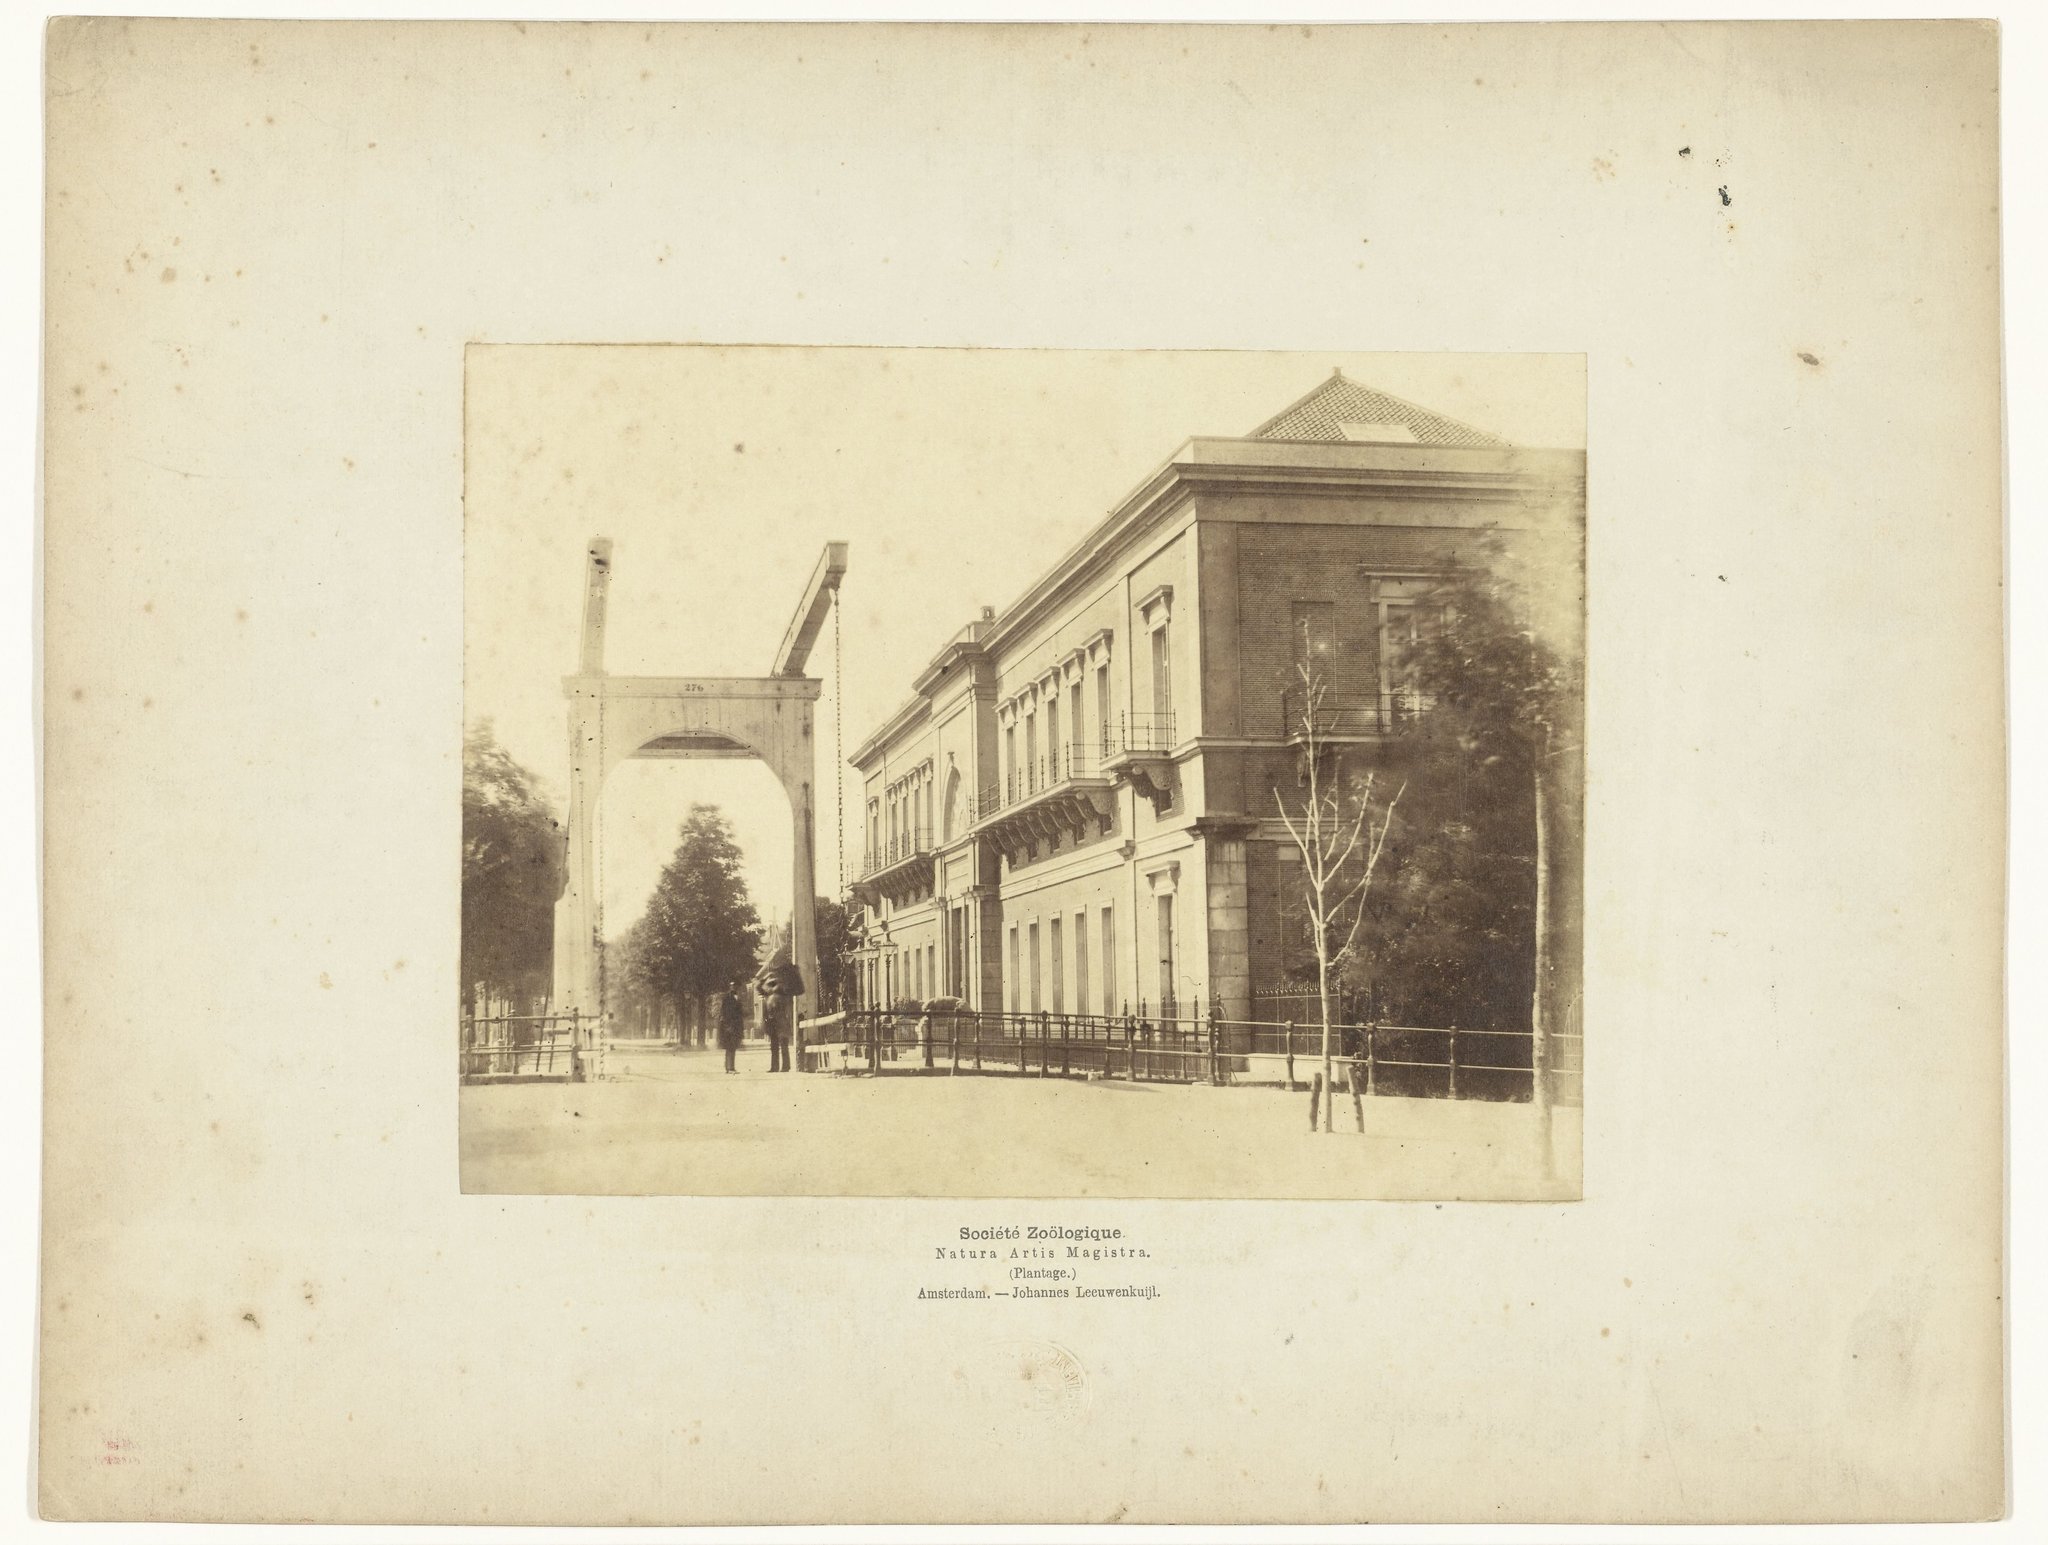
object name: photograph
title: Société Zoölogique. Natura Artis Magistra. (Plantage.)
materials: cardboard, paper, photographic support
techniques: albumen print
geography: haarlem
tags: zoological garden, zoo, seen as place where non-domestic animals are kept, bridge, street, amsterdam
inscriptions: check stamp: ‘M & E Photographie Haarlem’